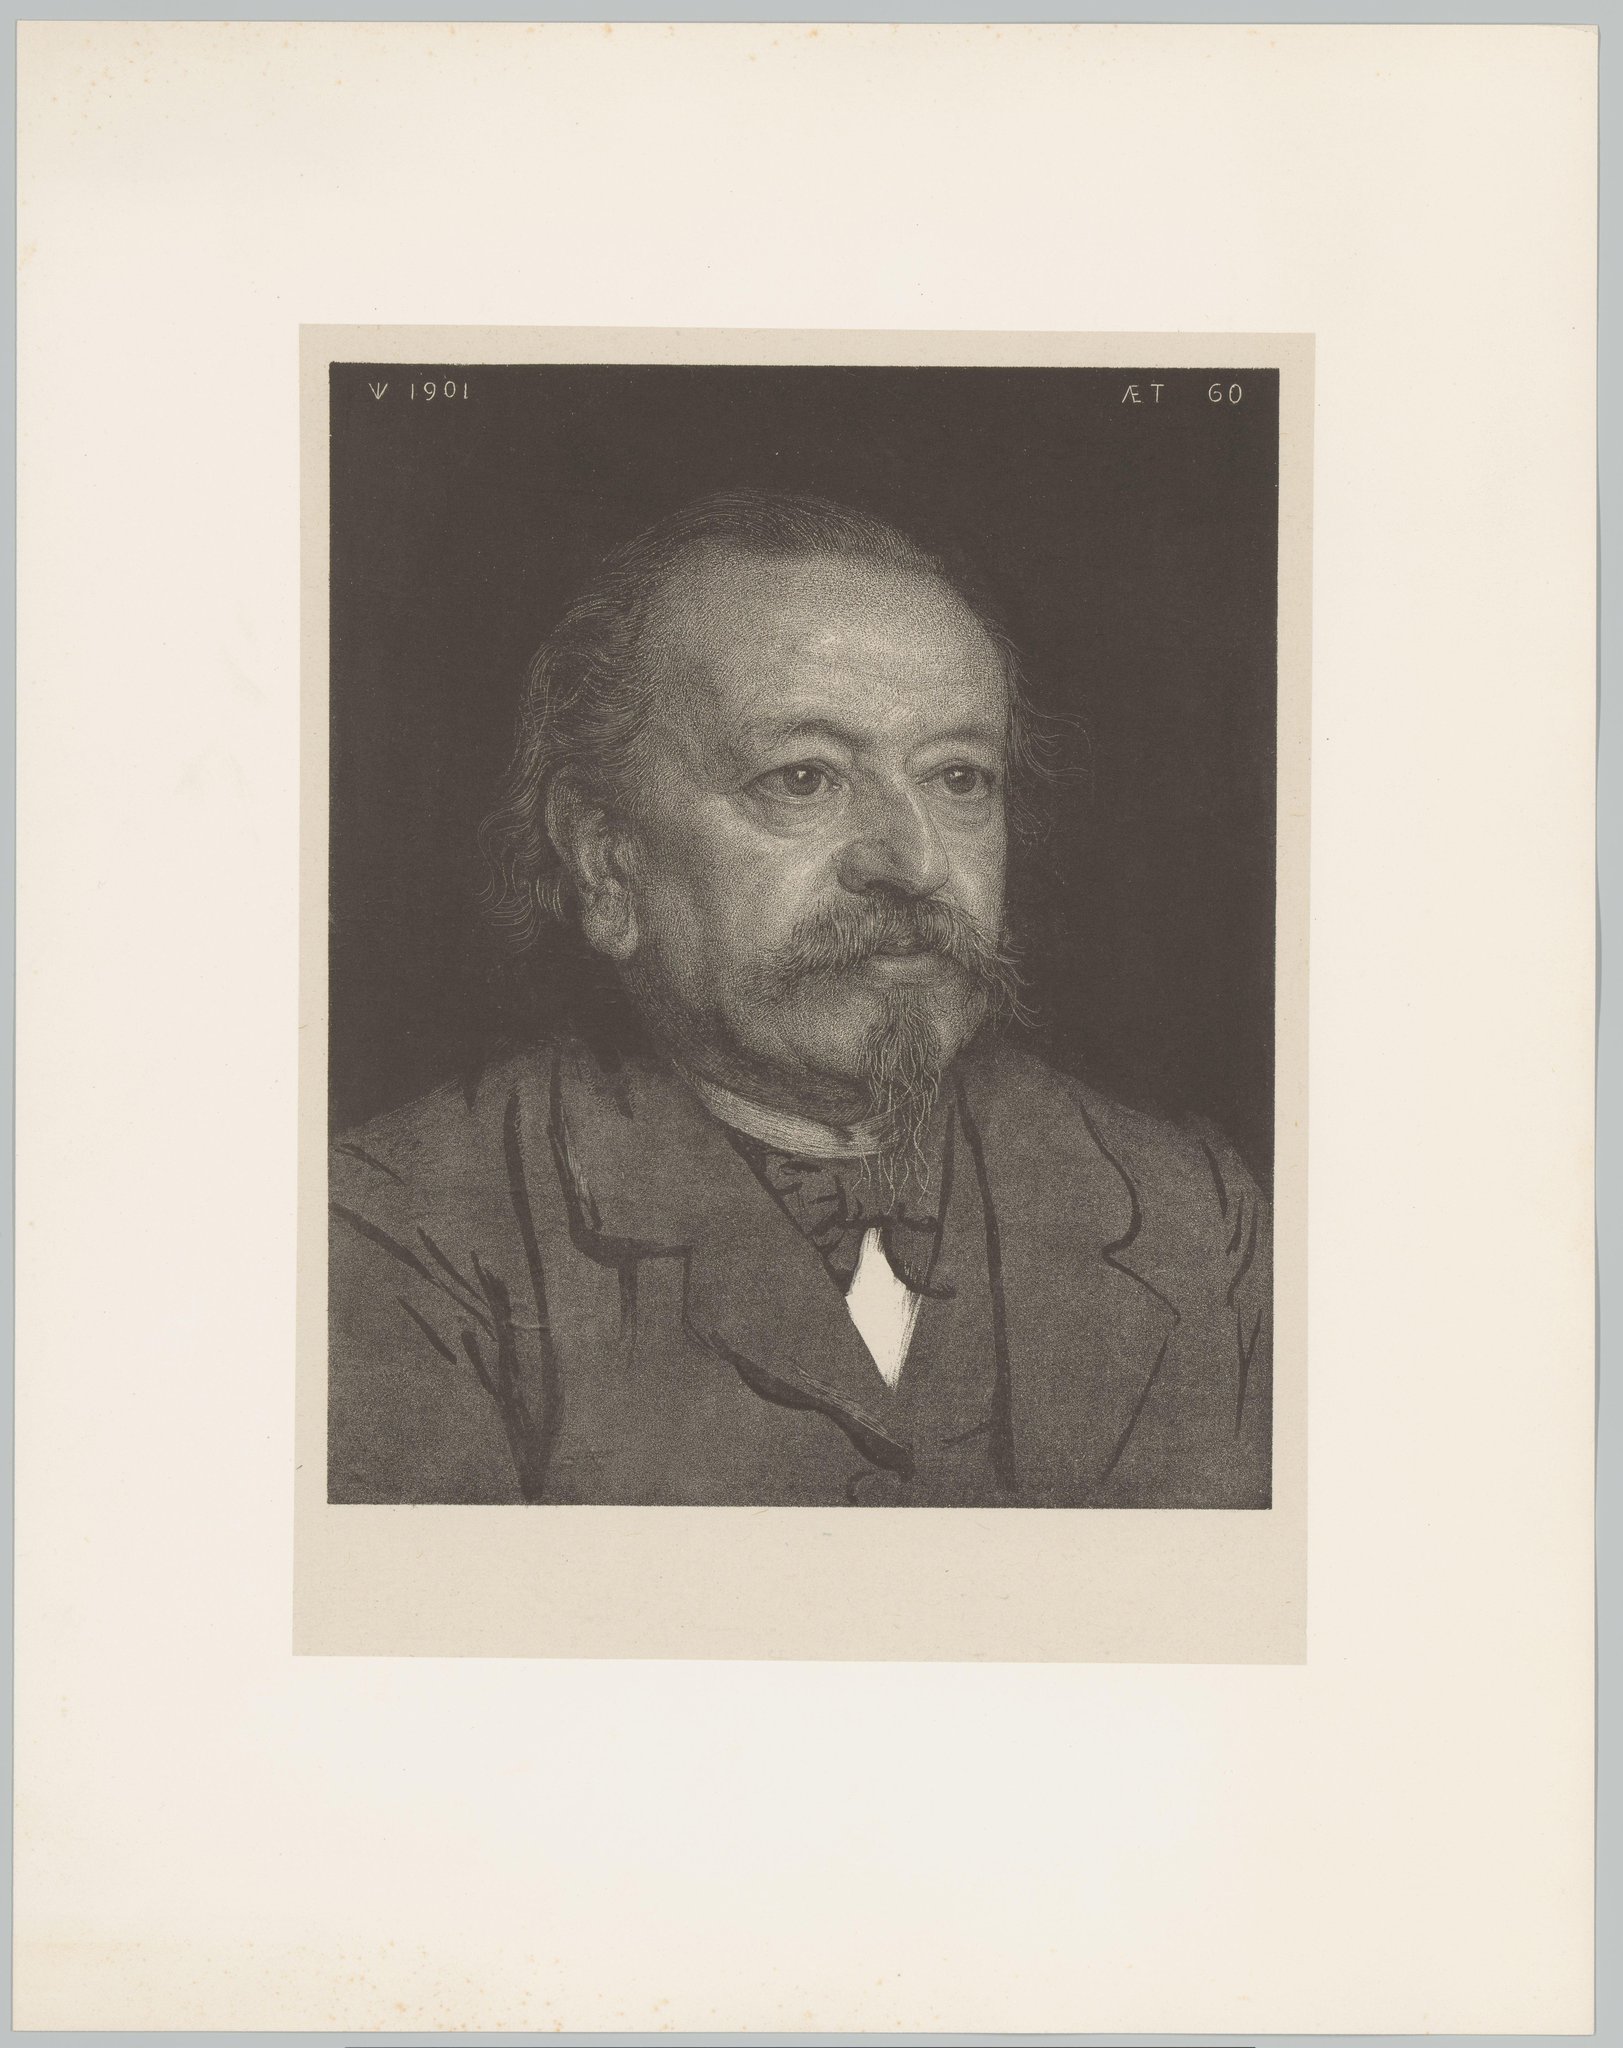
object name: print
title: Portret van Reinier Willem Petrus de Vries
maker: jan veth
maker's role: designer, draughtsman, painter, print maker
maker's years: 1864-1925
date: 1901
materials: paper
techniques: lithograph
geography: netherlands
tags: amsterdam, auctioneer, publisher, reinier willem petrus de vries (1841-1919), historical persons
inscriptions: collector's mark: Lugt 2228